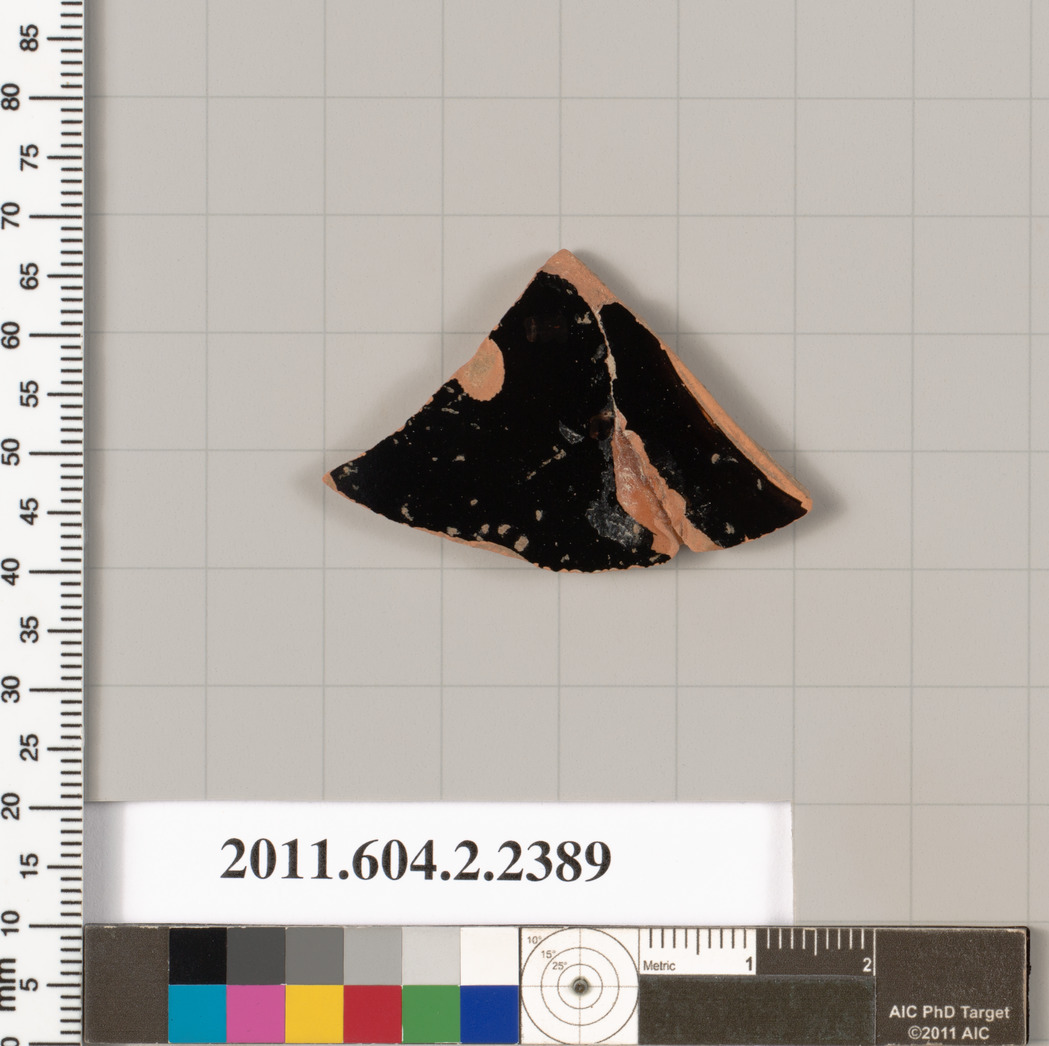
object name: pot fragment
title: Terracotta fragment of a pot; unglazed on the inside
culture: greek, attic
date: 500-470 BCE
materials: terracotta